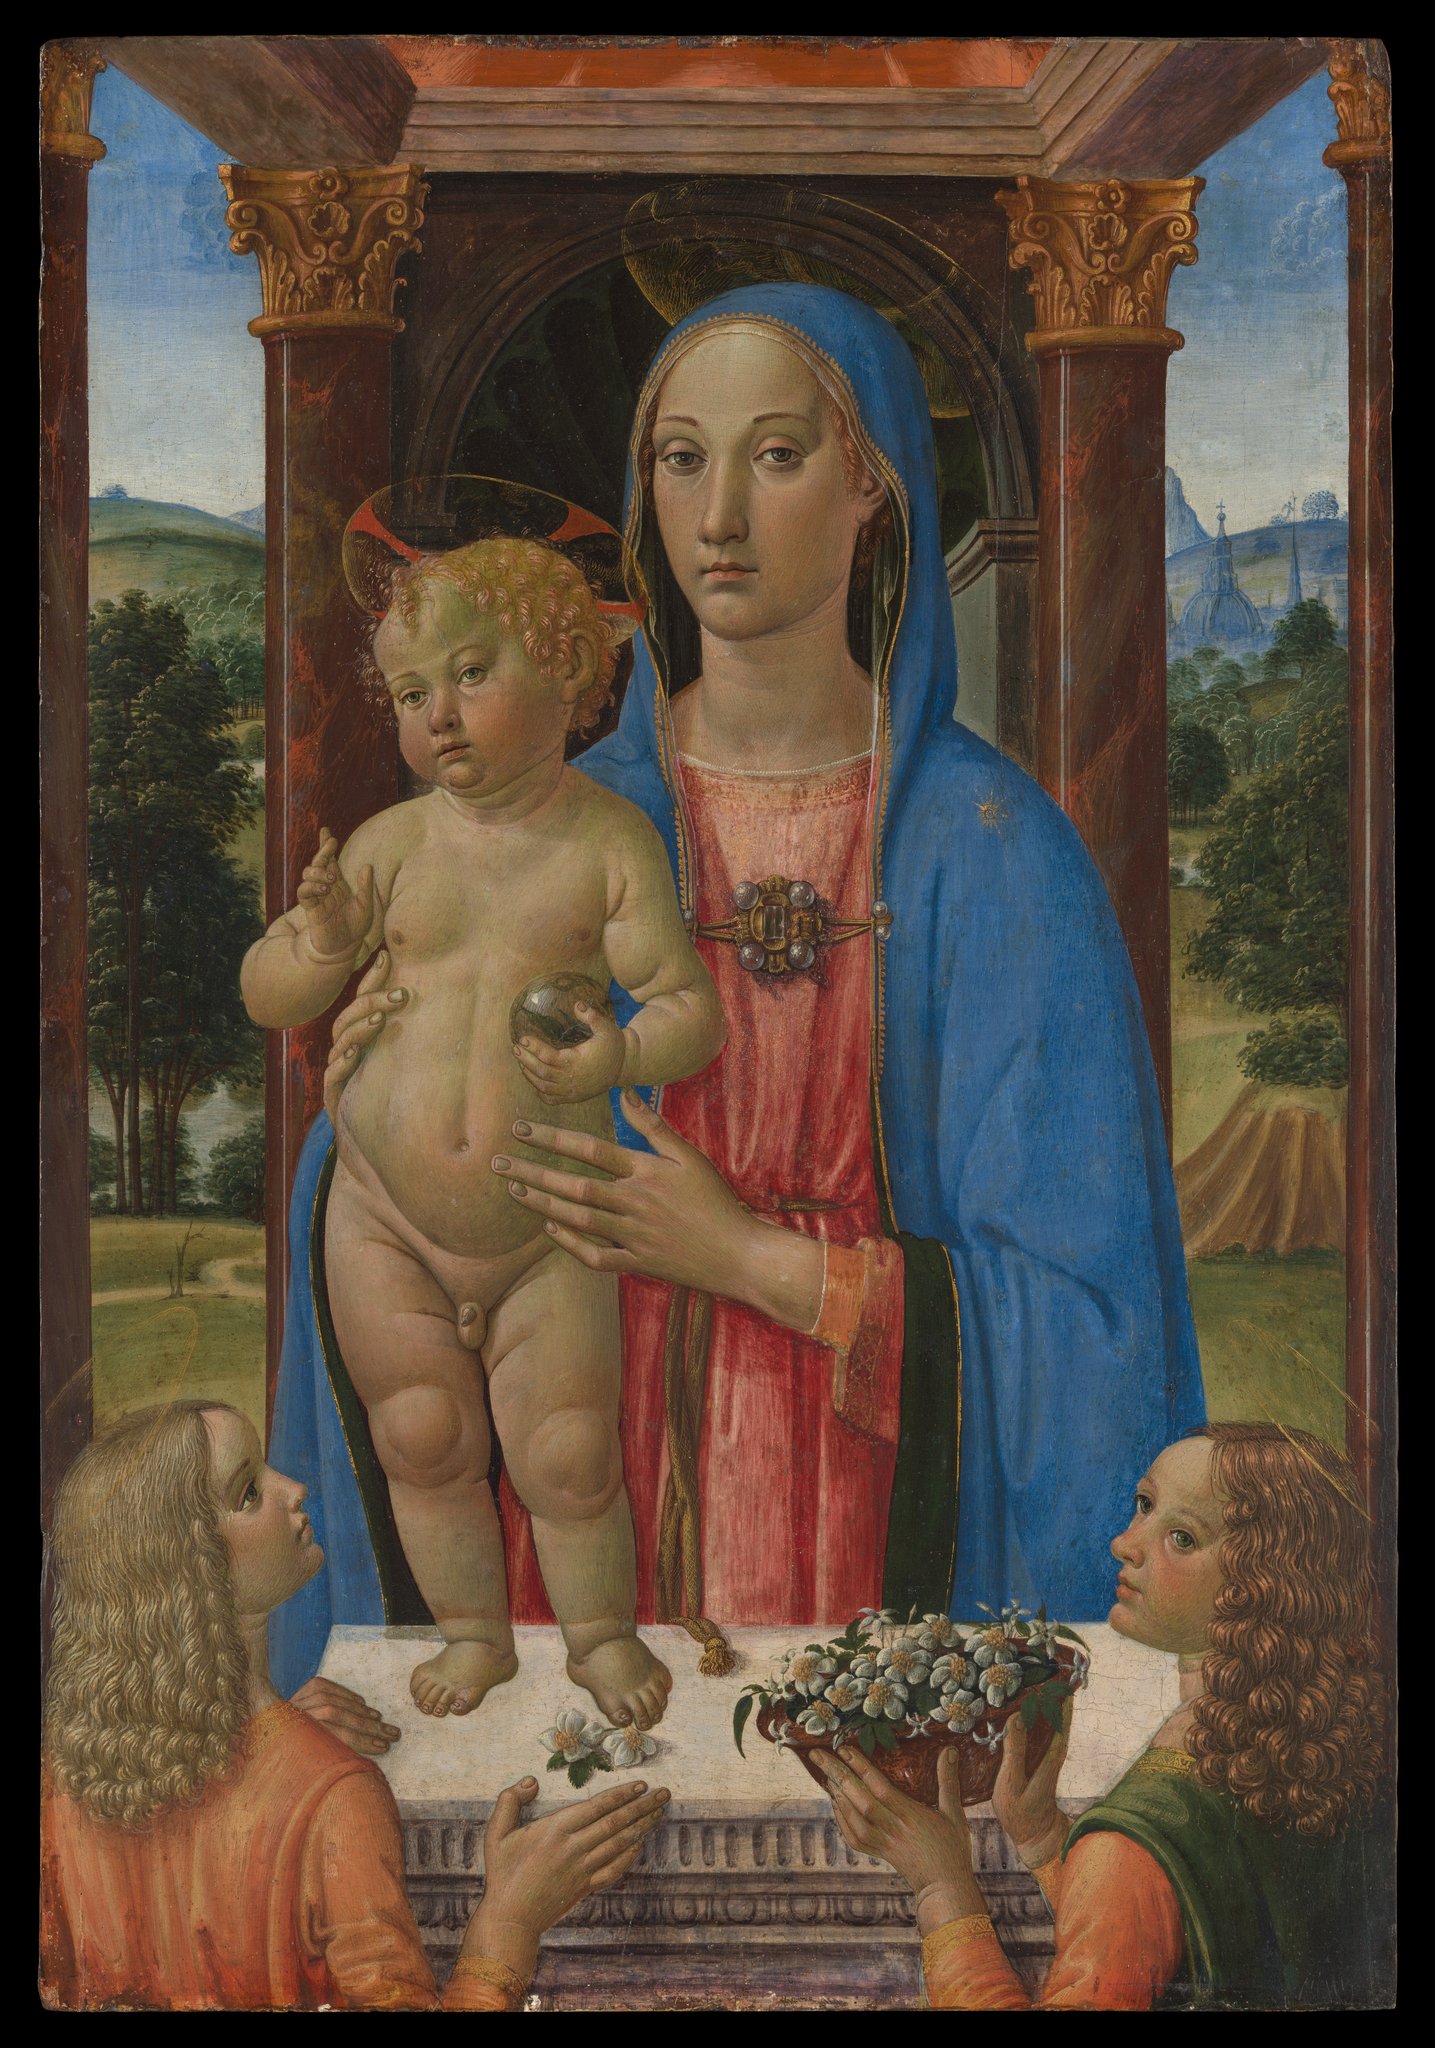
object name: painting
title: Madonna and Child with Two Angels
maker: cosimo rosselli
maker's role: artist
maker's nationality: italian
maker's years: 1440-1507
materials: gold, paint, wood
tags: angels,madonna and child